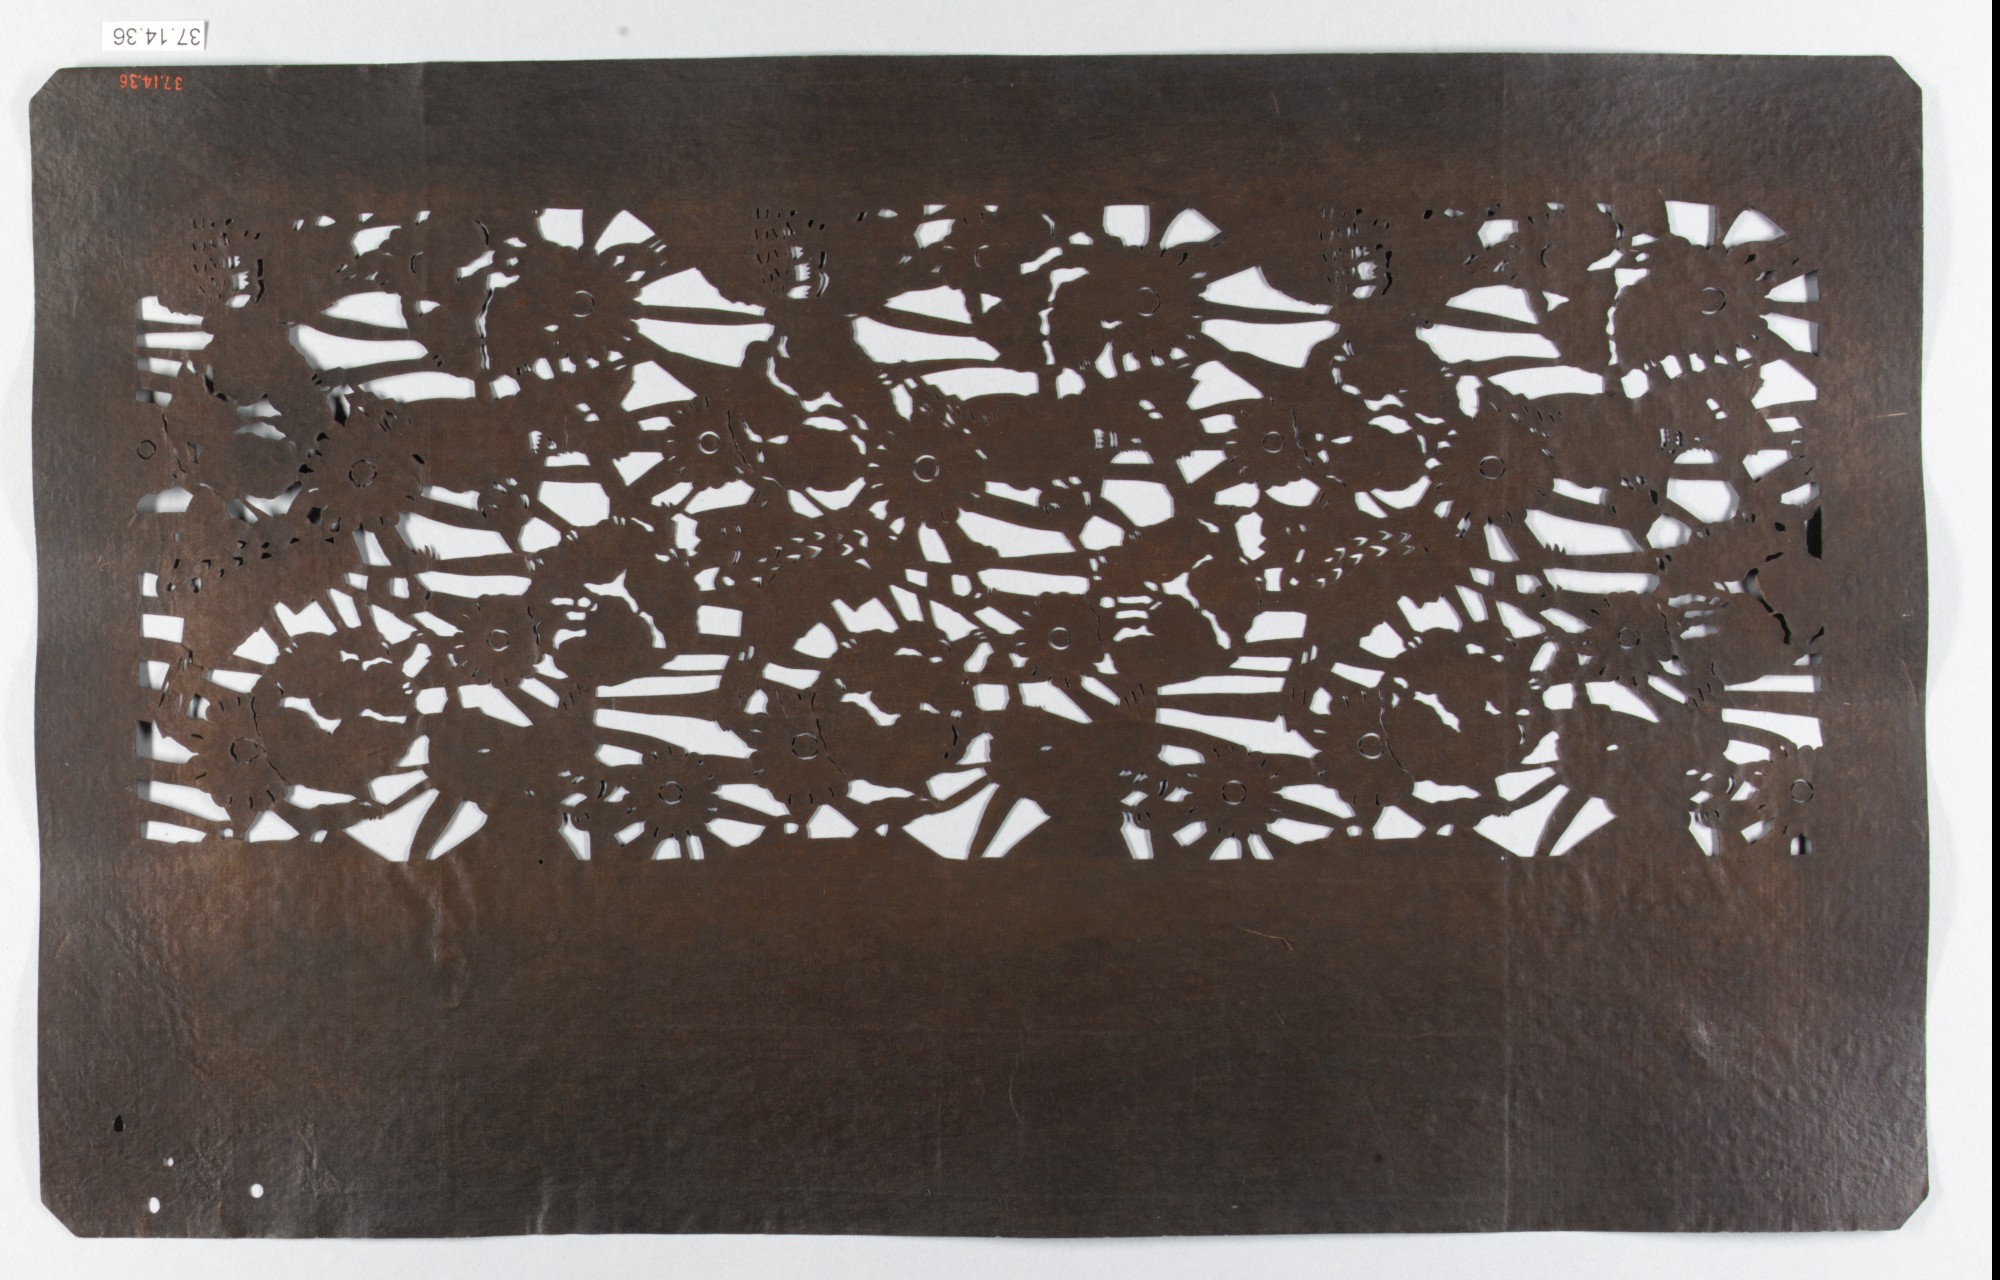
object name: stencil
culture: japanese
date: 1801-1833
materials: paper